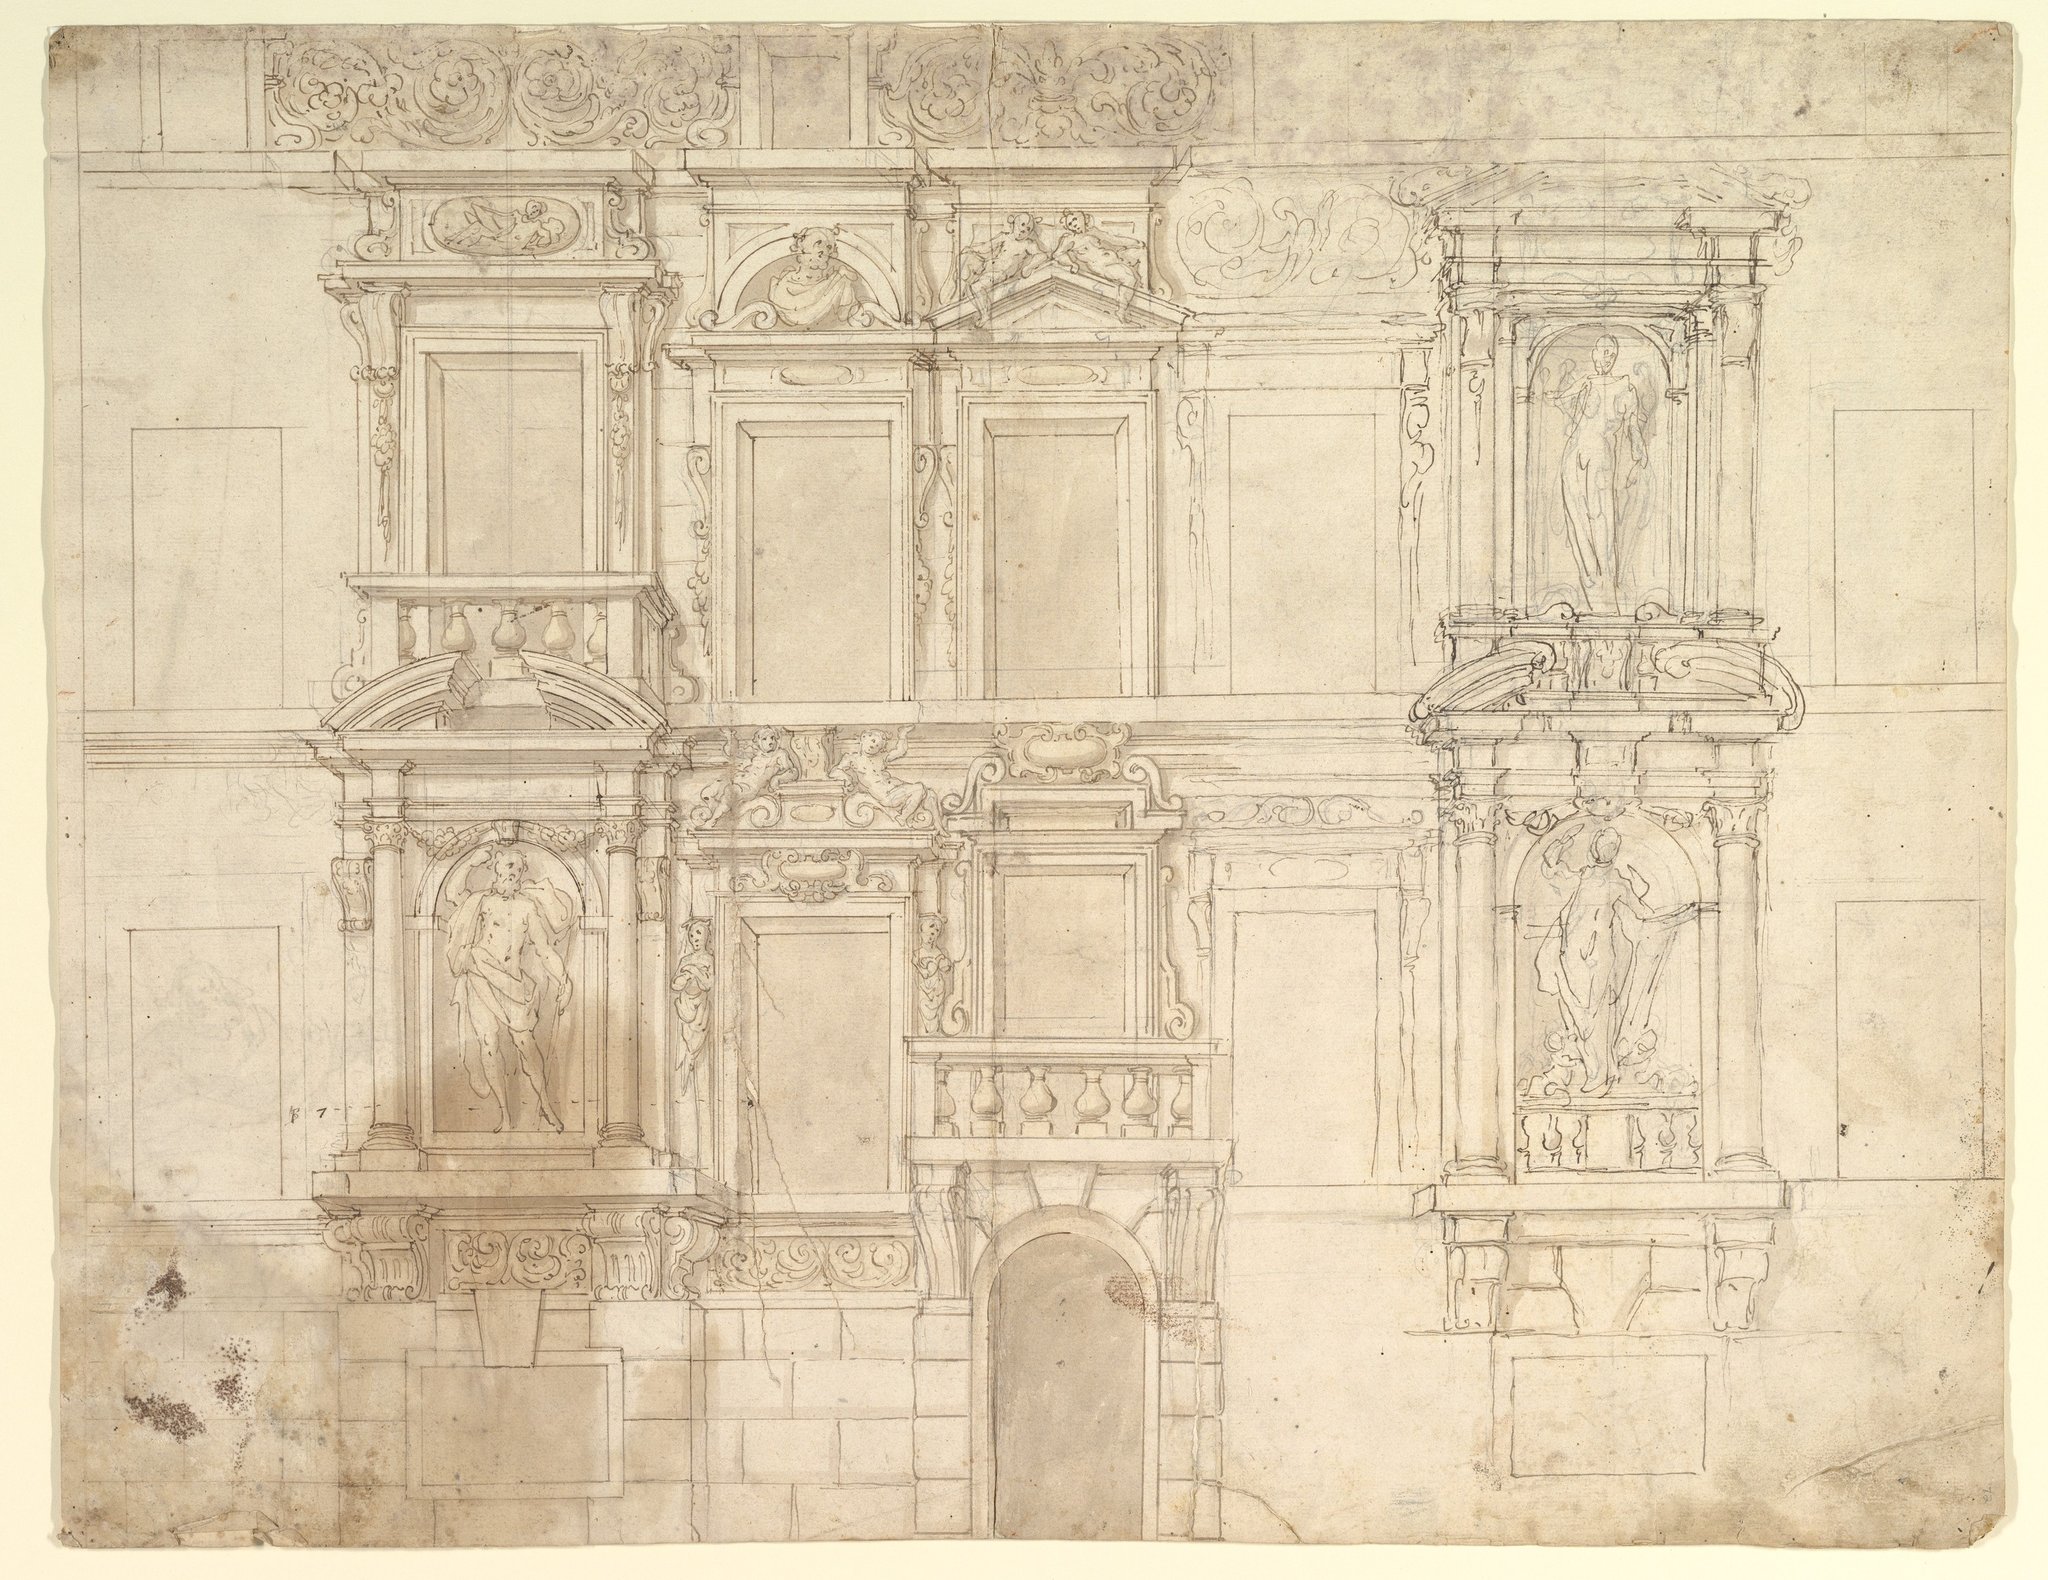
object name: drawing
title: Design for Exterior Wall Elevation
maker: anonymous, italian, piedmontese, 17th century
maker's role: artist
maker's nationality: italian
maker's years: 1600-1700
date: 1601-1700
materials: chalk, ink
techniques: brush, pen, wash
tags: architecture